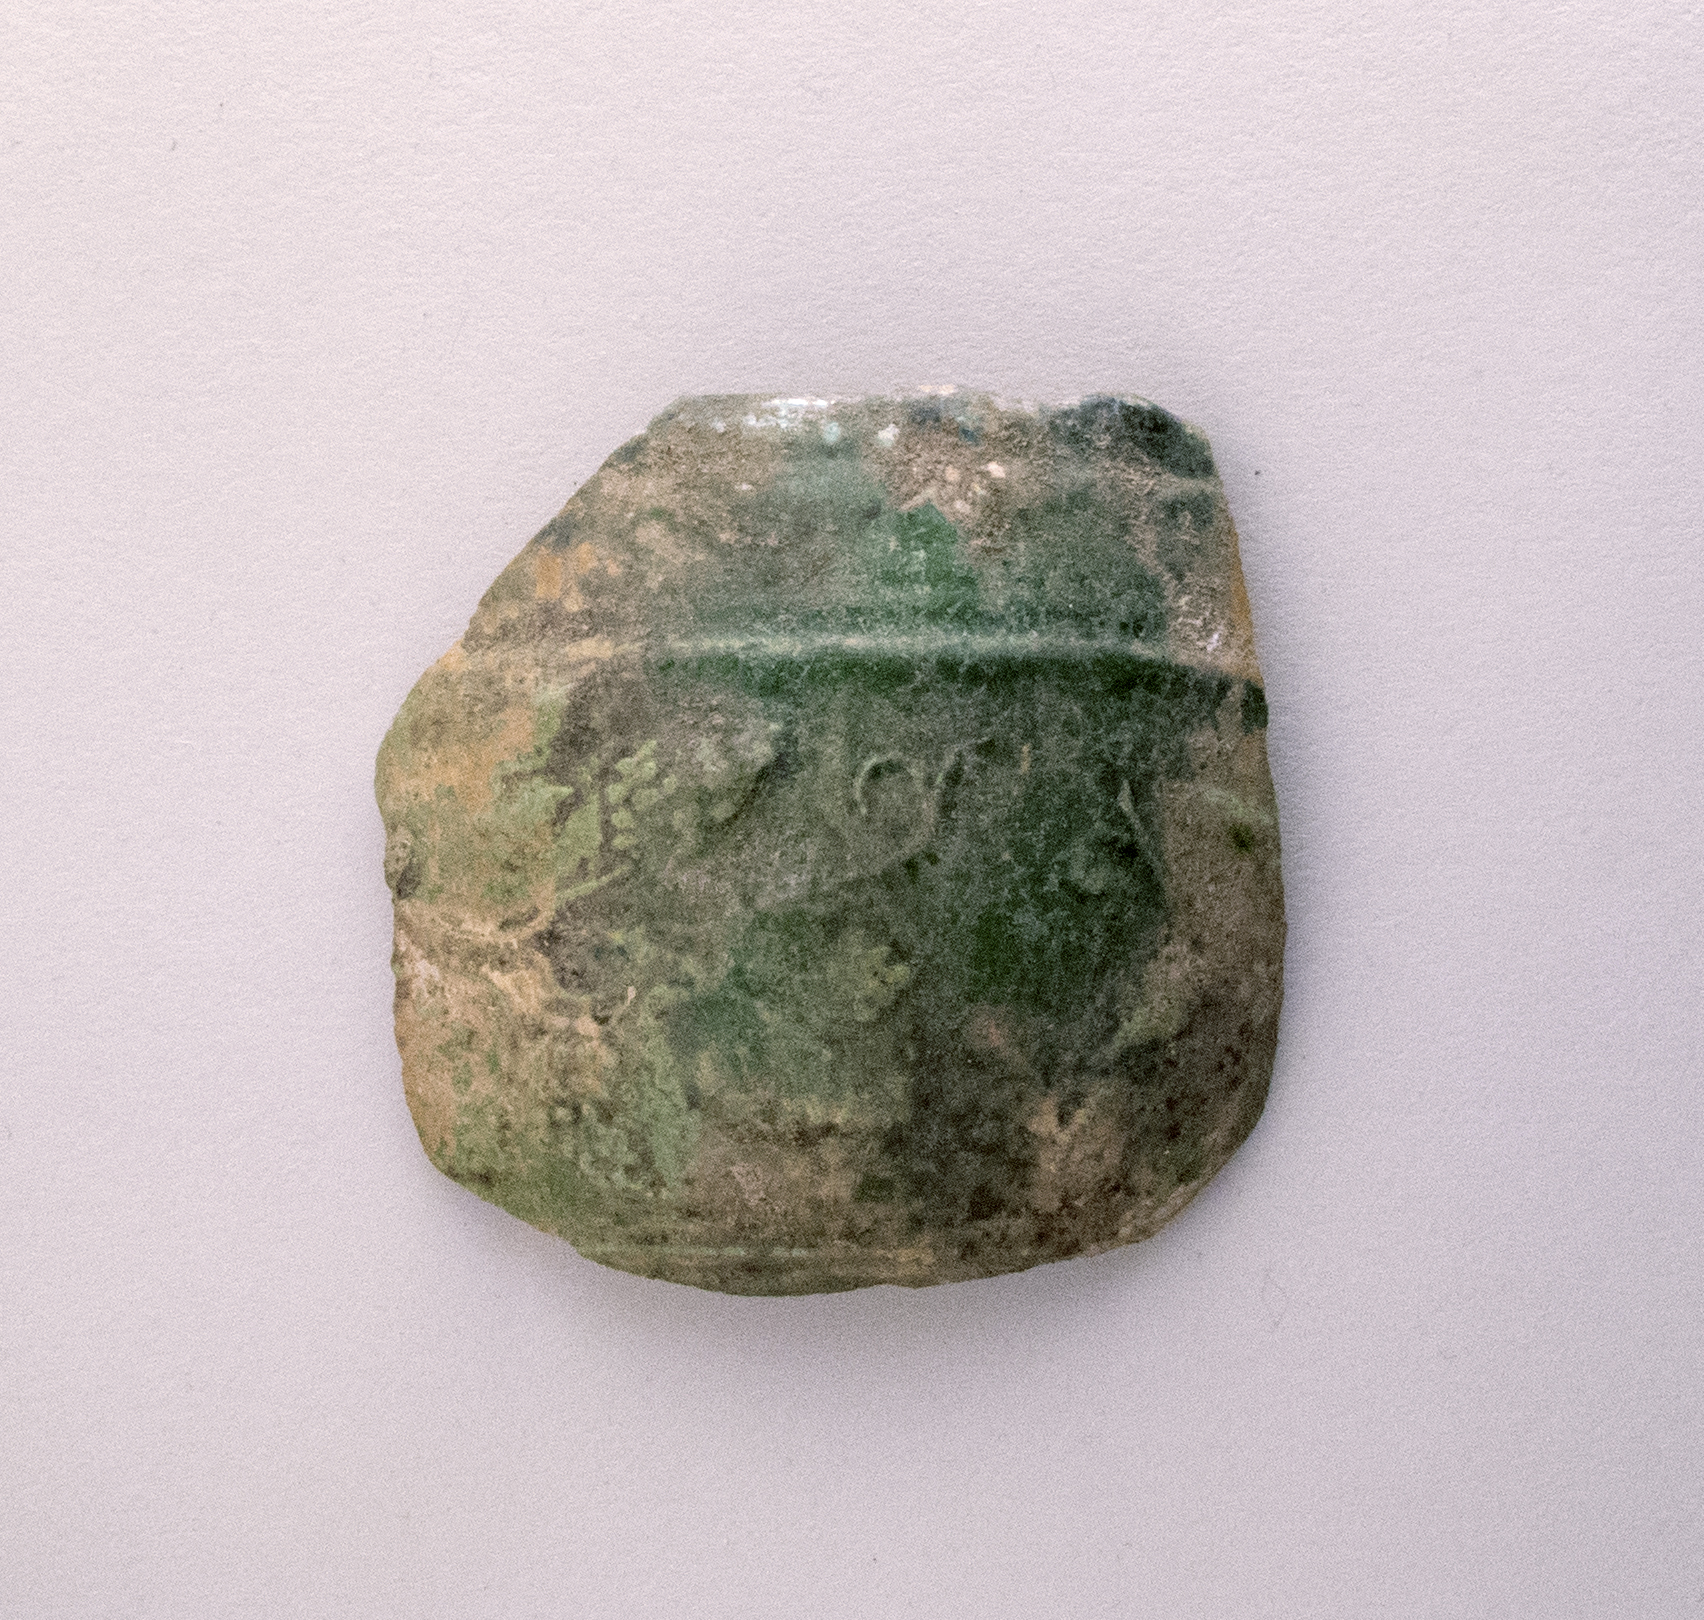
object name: vase fragment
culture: roman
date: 670 BCE-330 CE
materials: terracotta